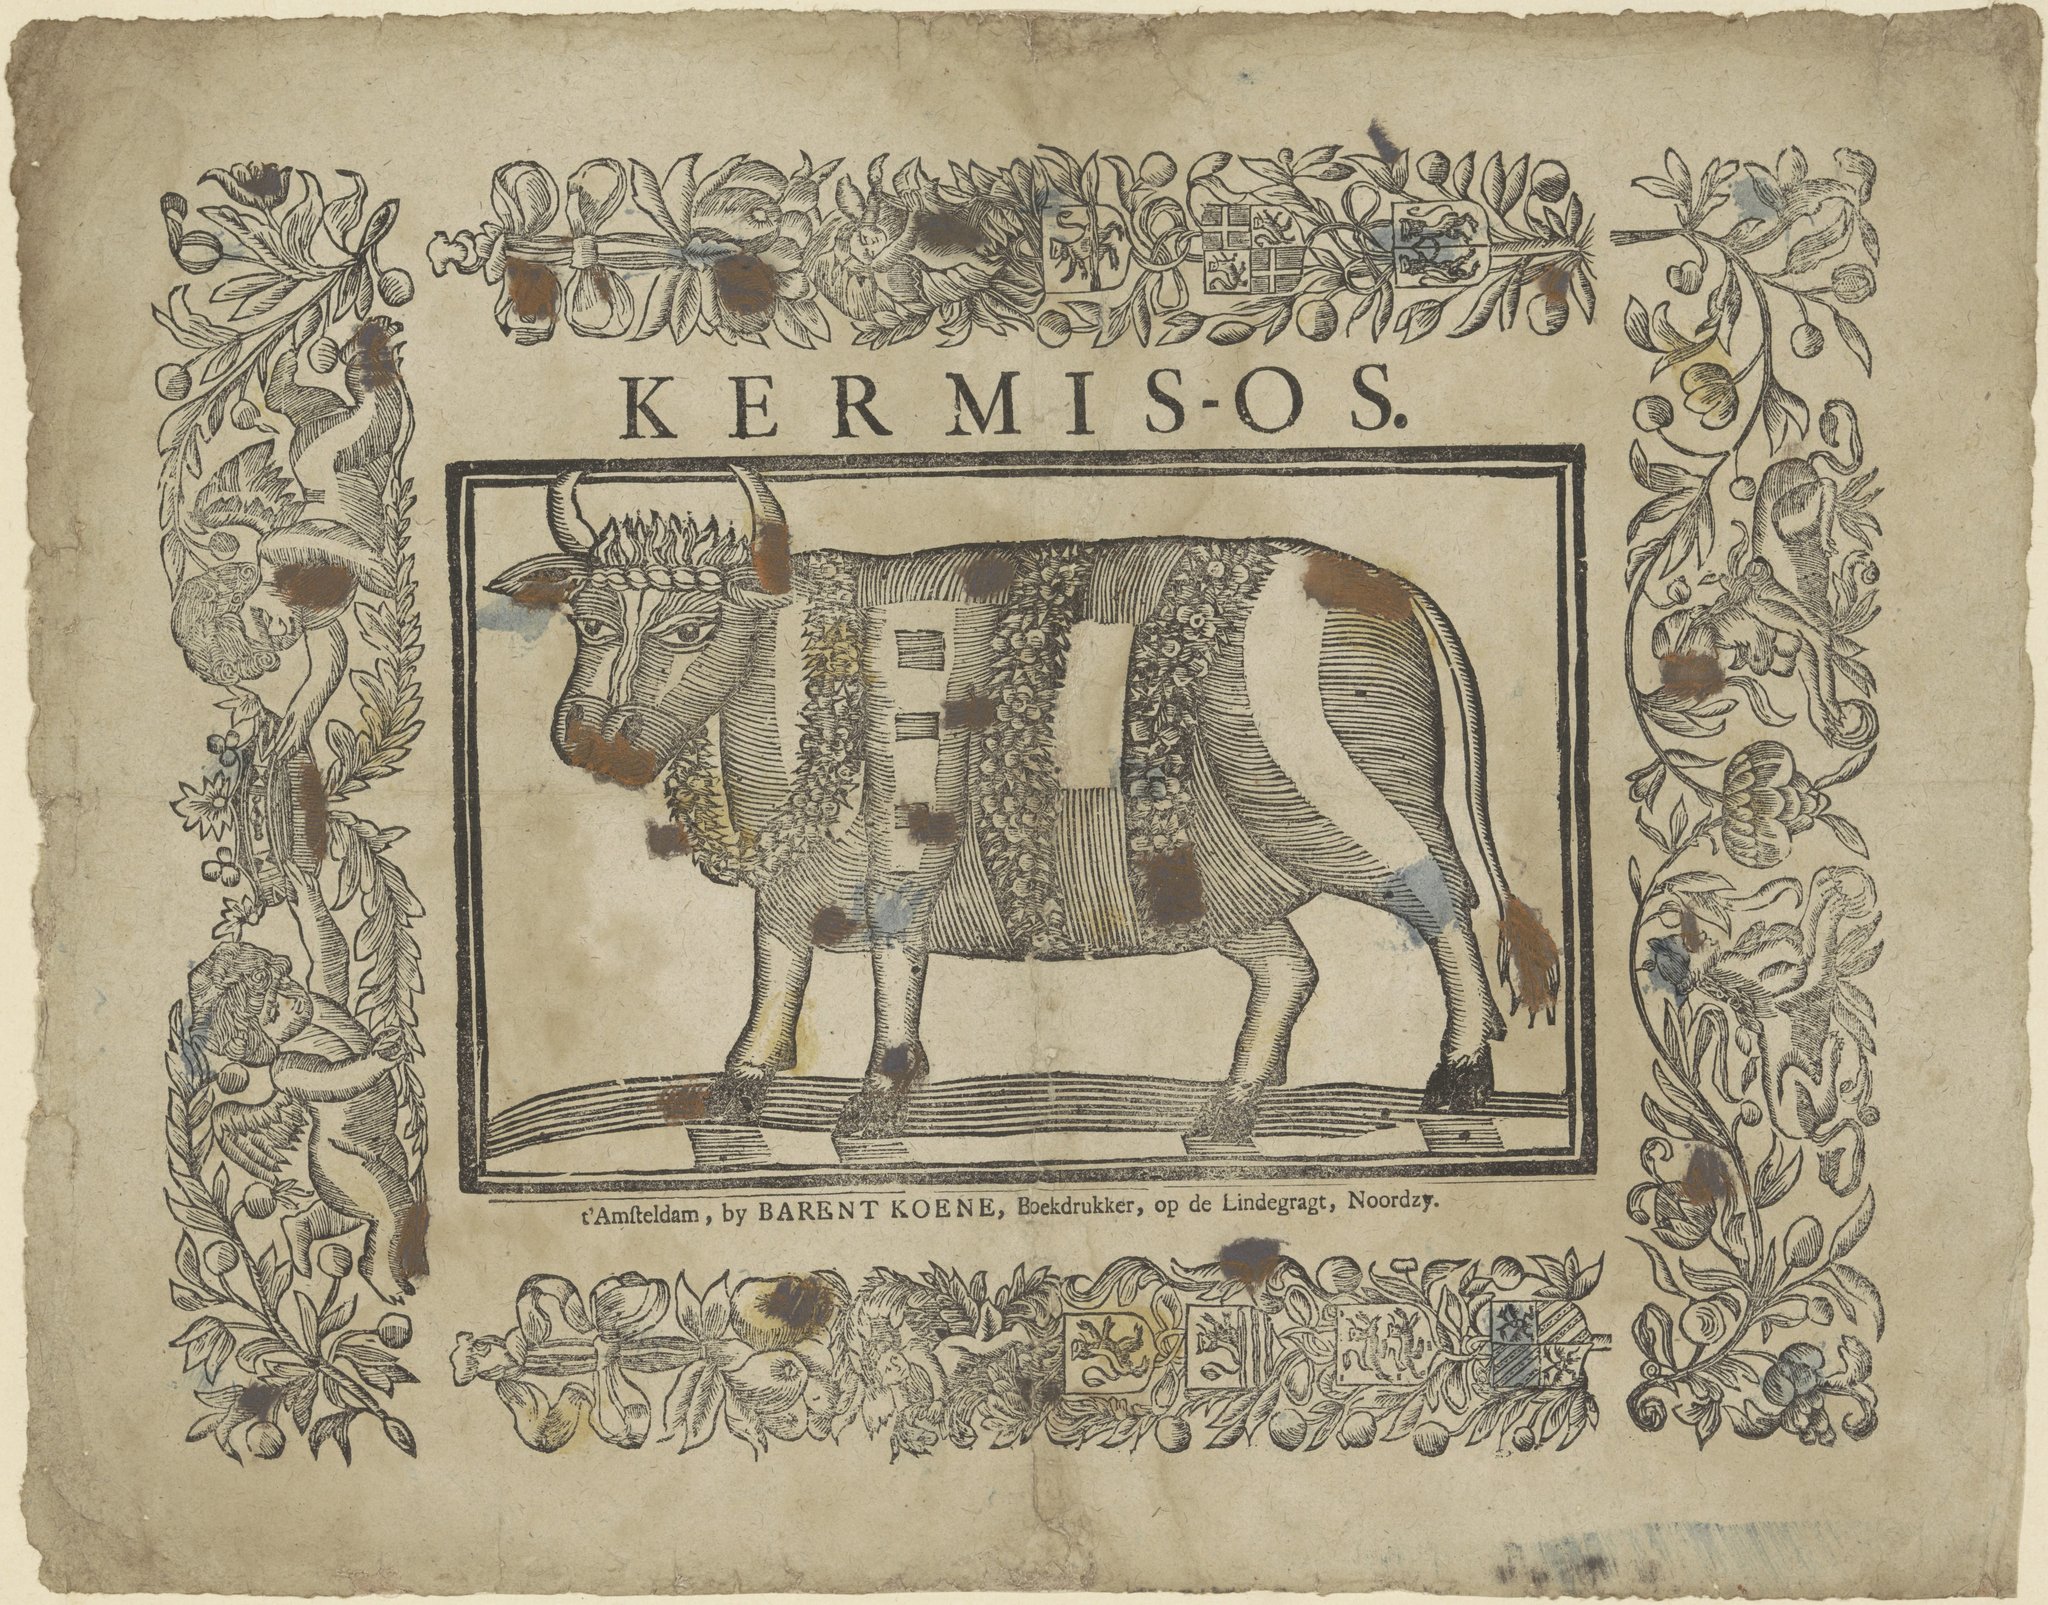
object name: print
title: Kermis-os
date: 1757-1781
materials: paper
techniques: colour, letterpress printing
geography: amsterdam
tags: floral interlace ~ ornament, prize-ox, ox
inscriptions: collector's mark: Lugt 2760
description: Blad met een grote voorstelling van een gilde-os (ook kermisos of prijsos genoemd), versierd met bloemenkransen. De voorstelling is gevat in een lijst van ranken met bloemen, vruchten, sfinxen en putti.